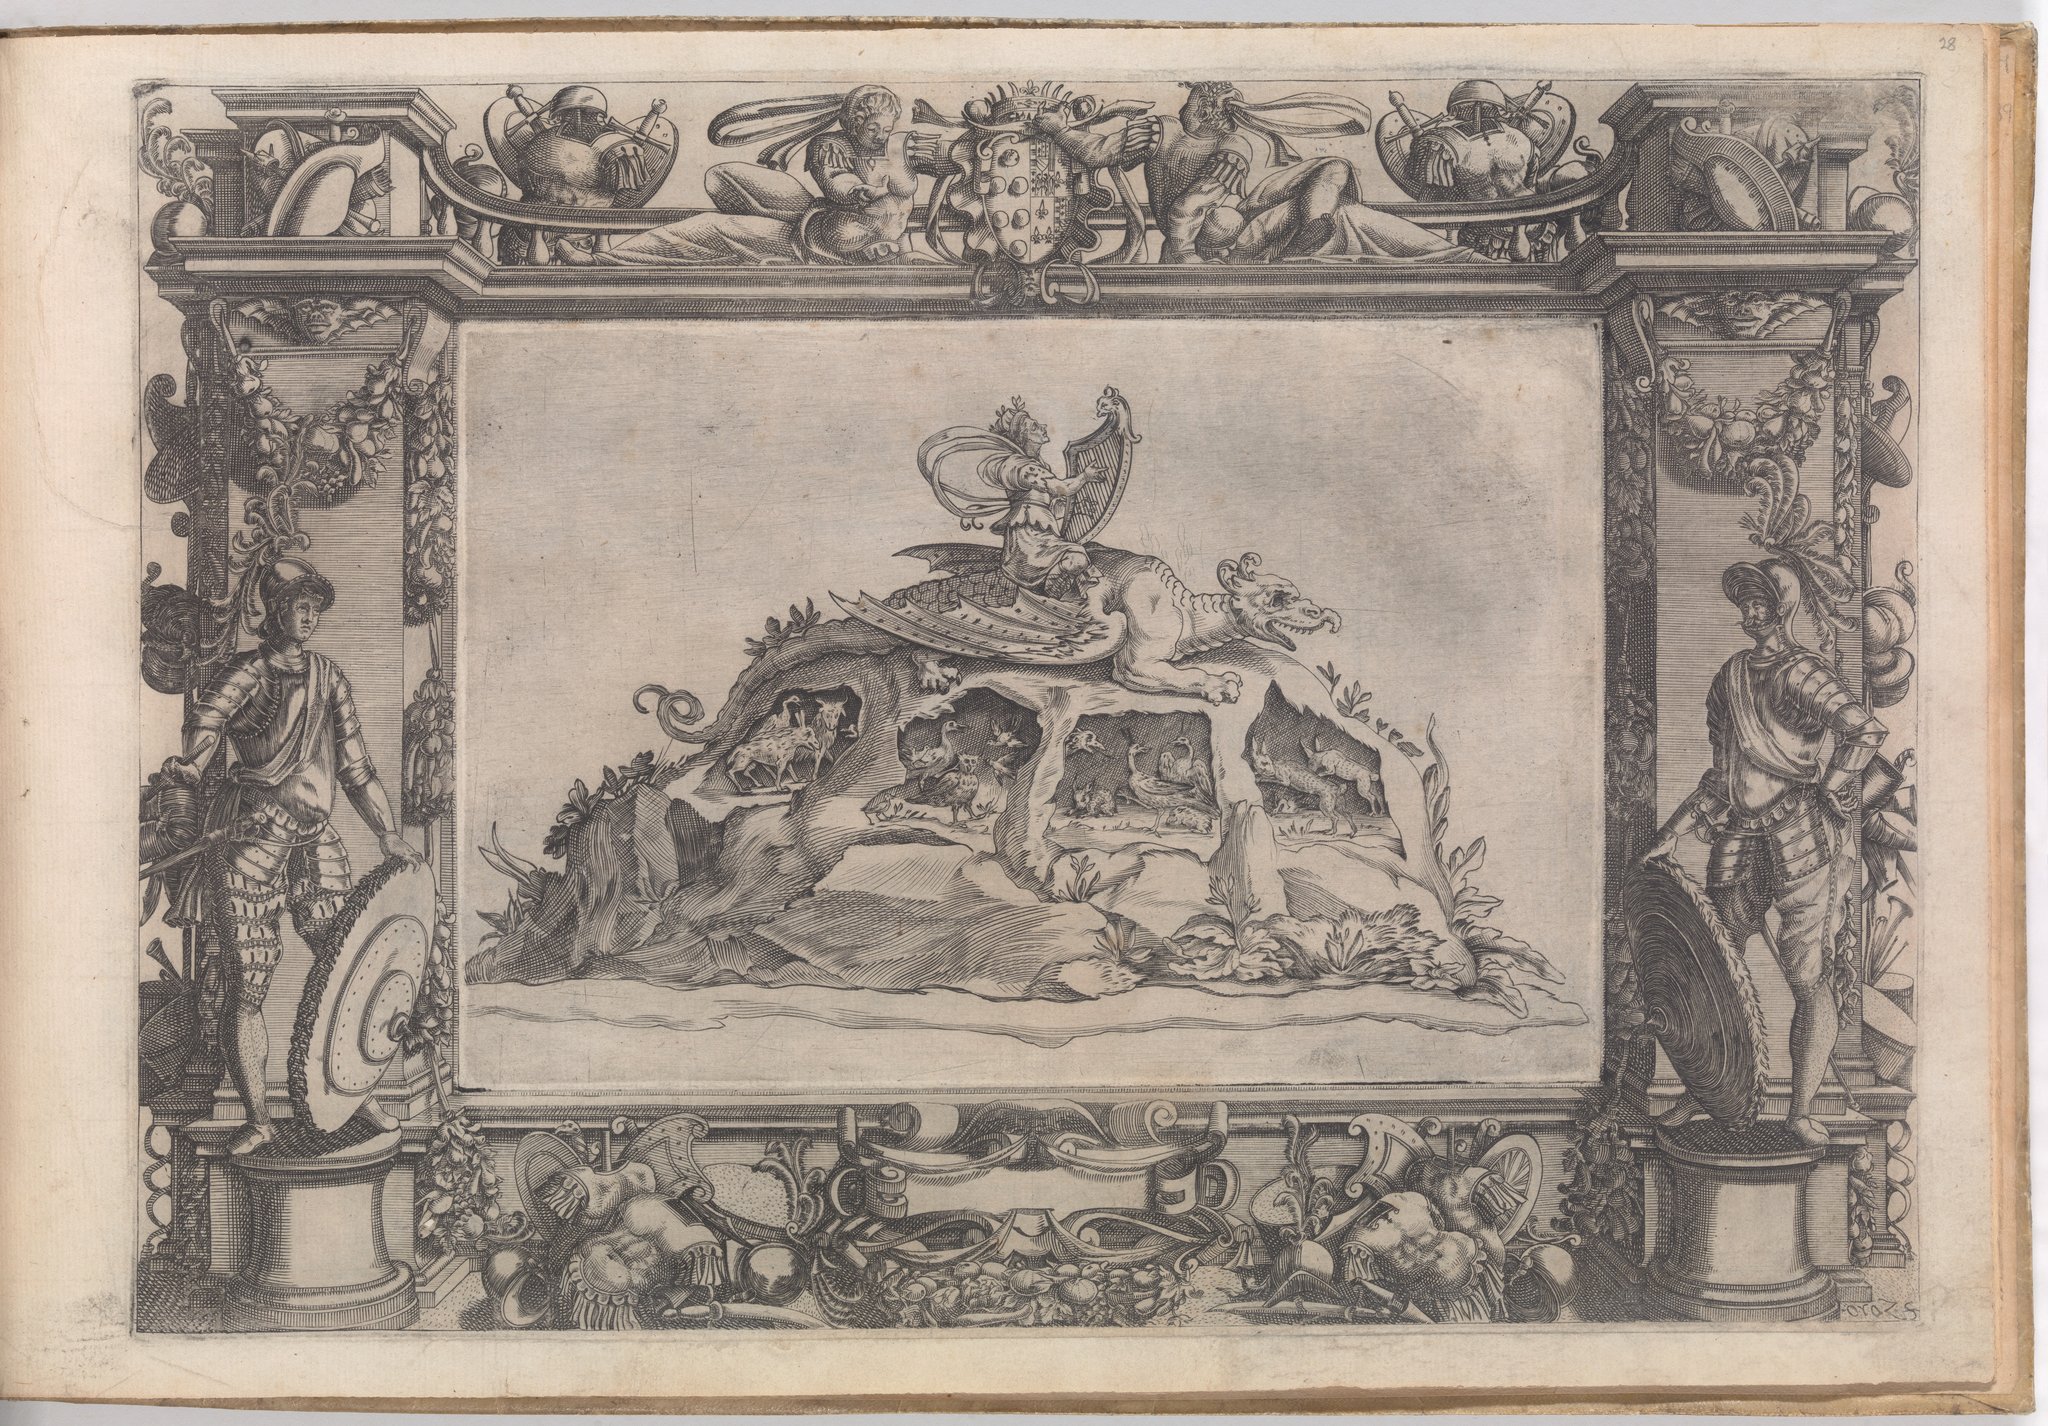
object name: book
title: Album with Prints recording the Festivities and Decorations organized in Florence for the 1589 Wedding of Archduke Ferdinand de' Medici and Christine of Lorraine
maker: bernardo buontalenti (bernardo delle girandole)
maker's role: artist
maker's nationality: italian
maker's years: 1526-1608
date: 1589-1592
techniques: etching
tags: men,women,fish,ships